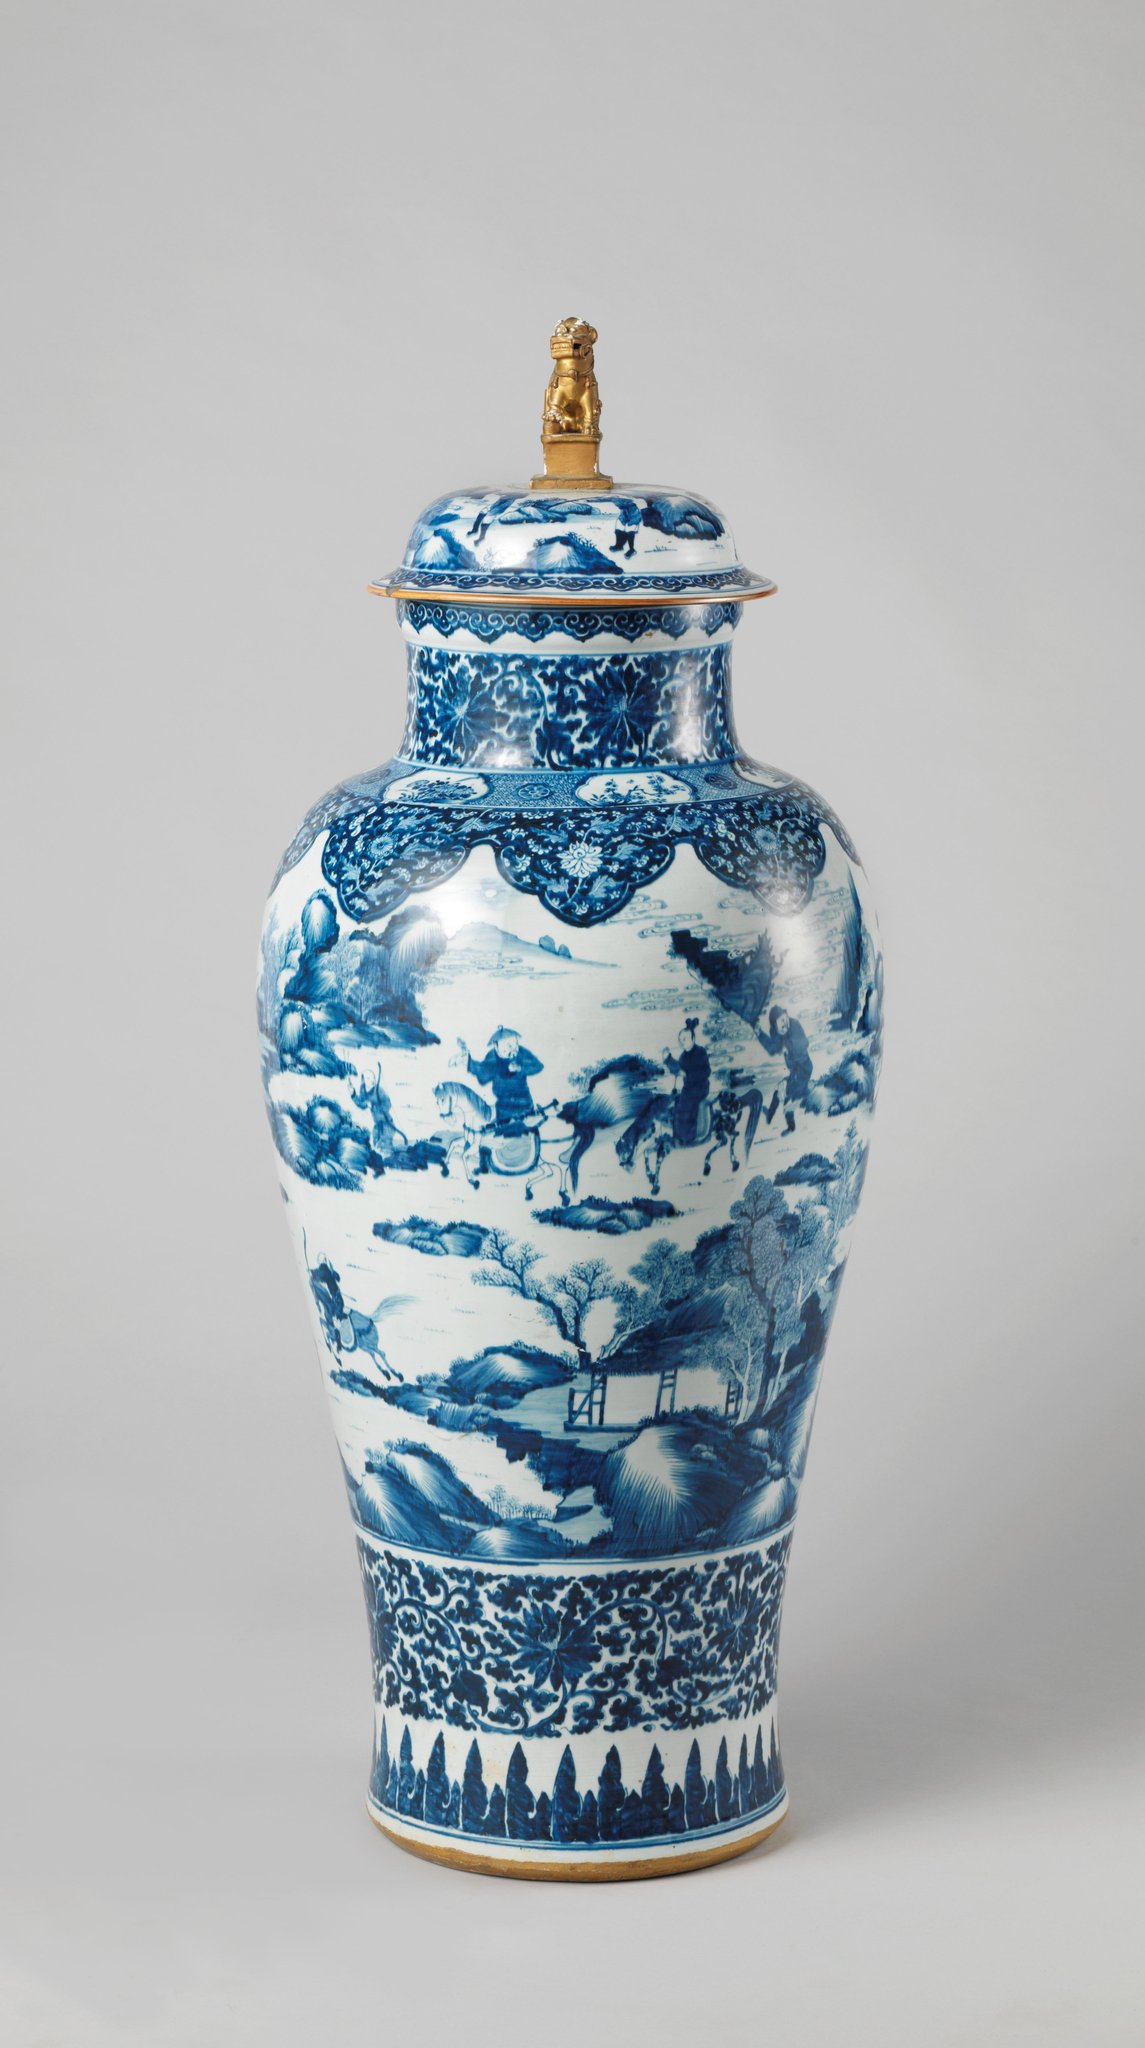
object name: vase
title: Baluster vase with a hunting scene and borders with floral scrolls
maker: Anonymous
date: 1700-1724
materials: cobalt, glaze, gold, paint, porcelain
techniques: firing, forming, gilding, turning, vitrification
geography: china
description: Grote, balustervormige vaas van porselein, beschilderd in onderglazuur blauw en op het glazuur goud. Op de buik een jachtscène met jagers te paard en te voet met wapens en honden in een landschap met bomen, bergen en rotsen. Hieronder een band met lotusranken. Boven de voet een band met staande bladmotieven. Op de schouder een band met lambrequins met daarin afwisselend lotus- en bloemranken. Daarboven een band met serverwerk met een bloemrozet onderbroken door cartouches met bloeiende planten (lotus, pioen, bamboe, chrysant, prunus). De nek met een band met lotusranken. Op de rand een band met ruyi-motief. Blauw-wit.